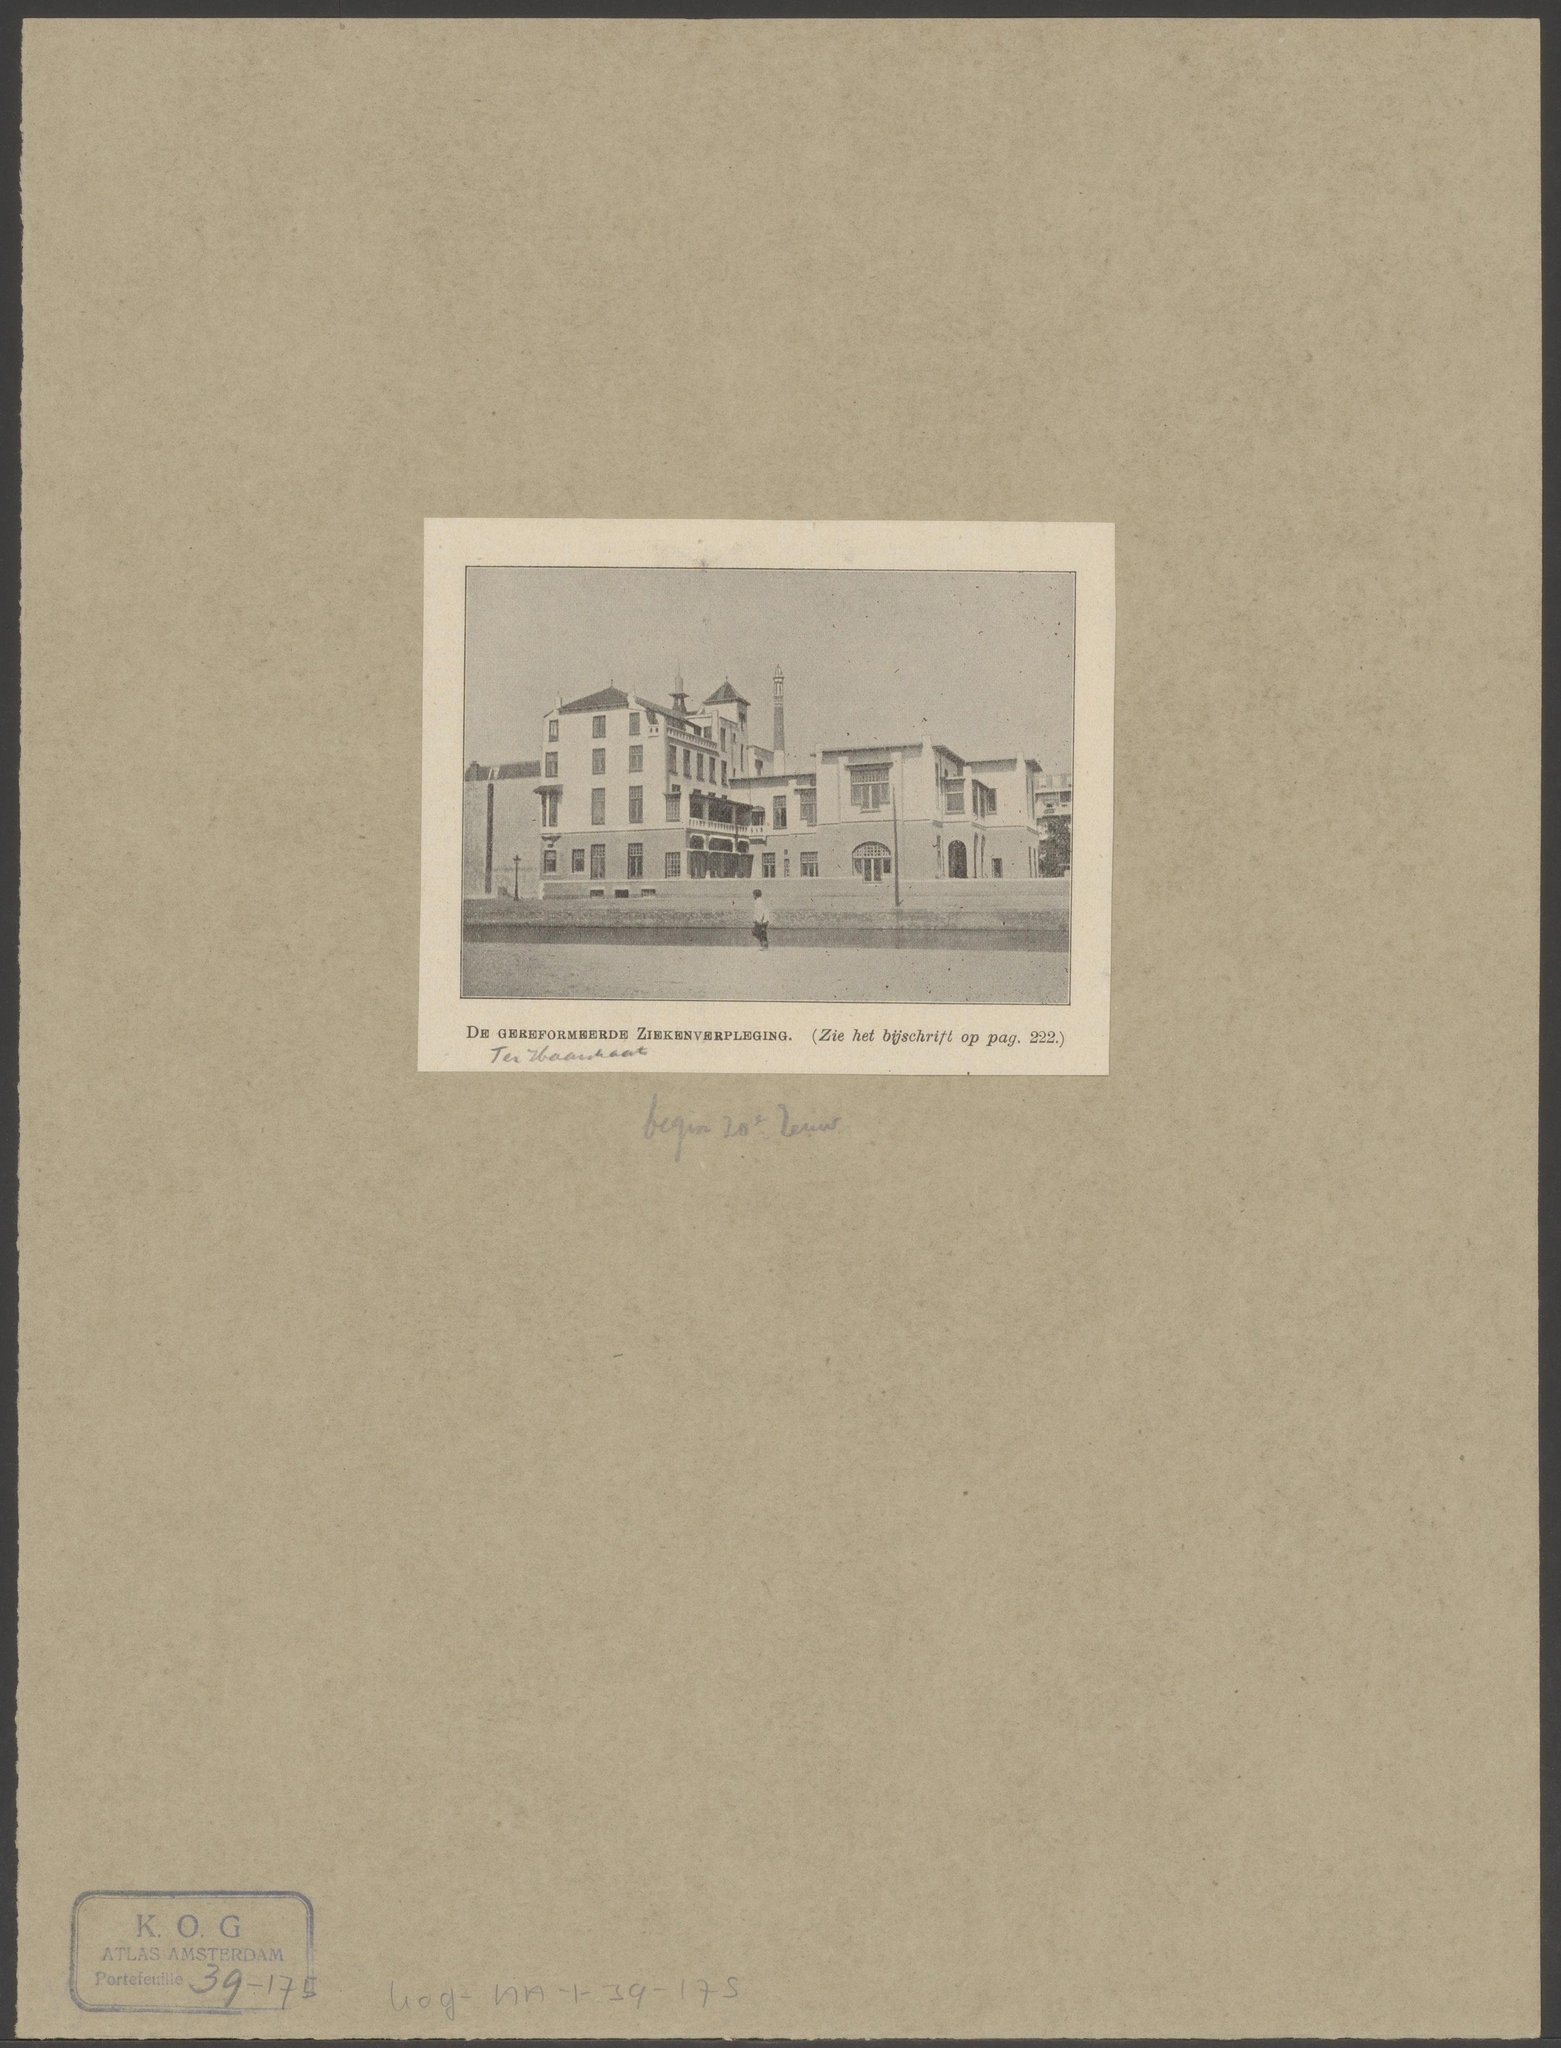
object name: photomechanical print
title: De Gereformeerde Ziekenverpleging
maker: Anonymous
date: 1904-1928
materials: paper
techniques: letterpress printing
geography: netherlands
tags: hospital, canals, waters (in city) (+ city(-scape) with figures, staffage)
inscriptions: collector's mark: Lugt 1641b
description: Onderwerpsrubriek binnen de Atlas Amsterdam: Armwezen en liefdadige instellingen: V. Ziekenhuizen: Burgerziekenhuis - Boerhaavekliniek - Gasthuis der Ned. Ver. tegen Vallende Ziekte - Diaconessenhuis Keizersgracht - Diaconessenhuis Overtoom - Gereformeerde Ziekenverpleging.